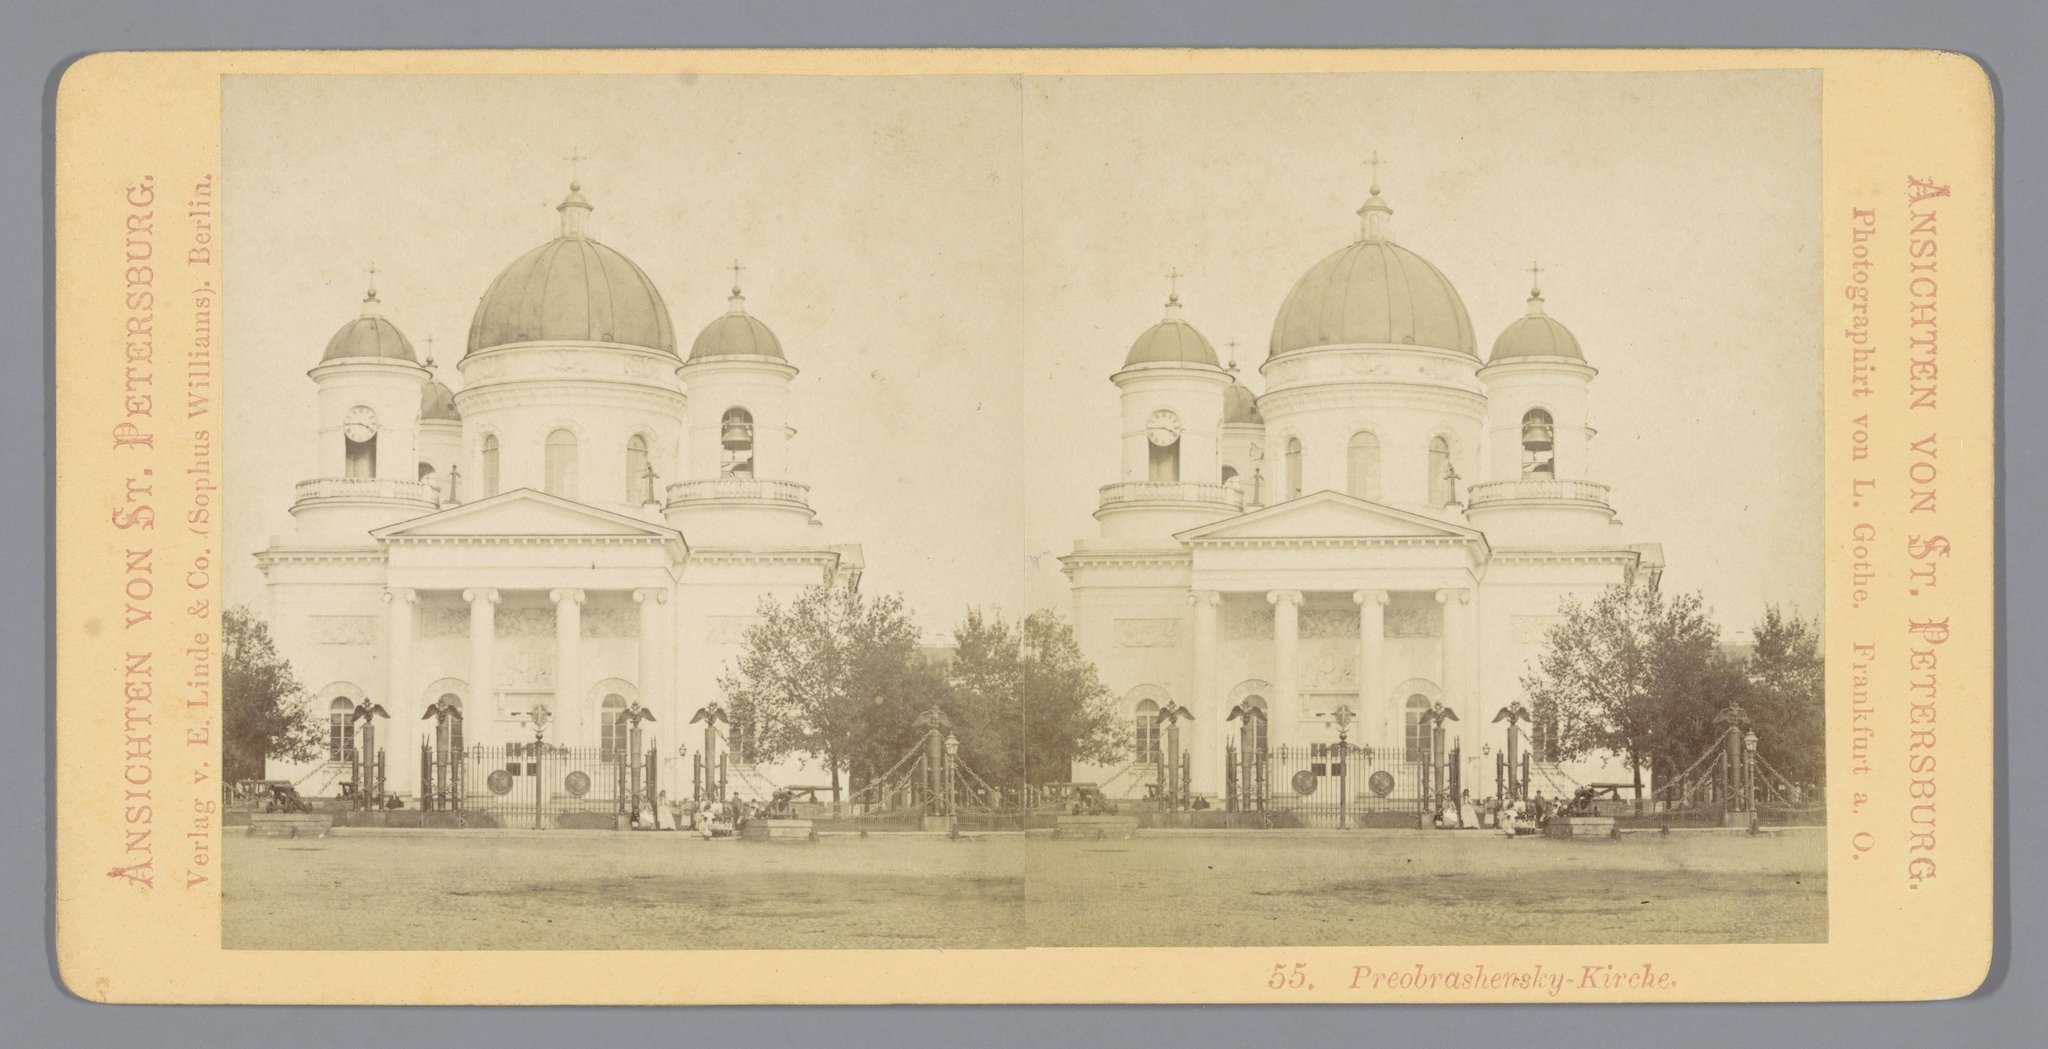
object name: stereograph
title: Preobrashensky-Kirche.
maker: louis gothe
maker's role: fotograaf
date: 1850-1880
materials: cardboard, photographic support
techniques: albumen print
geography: berlin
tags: church (exterior), dome ~ architecture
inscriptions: number: ‘55.’, inscription: ‘Ansichten von St. Petersburg.’